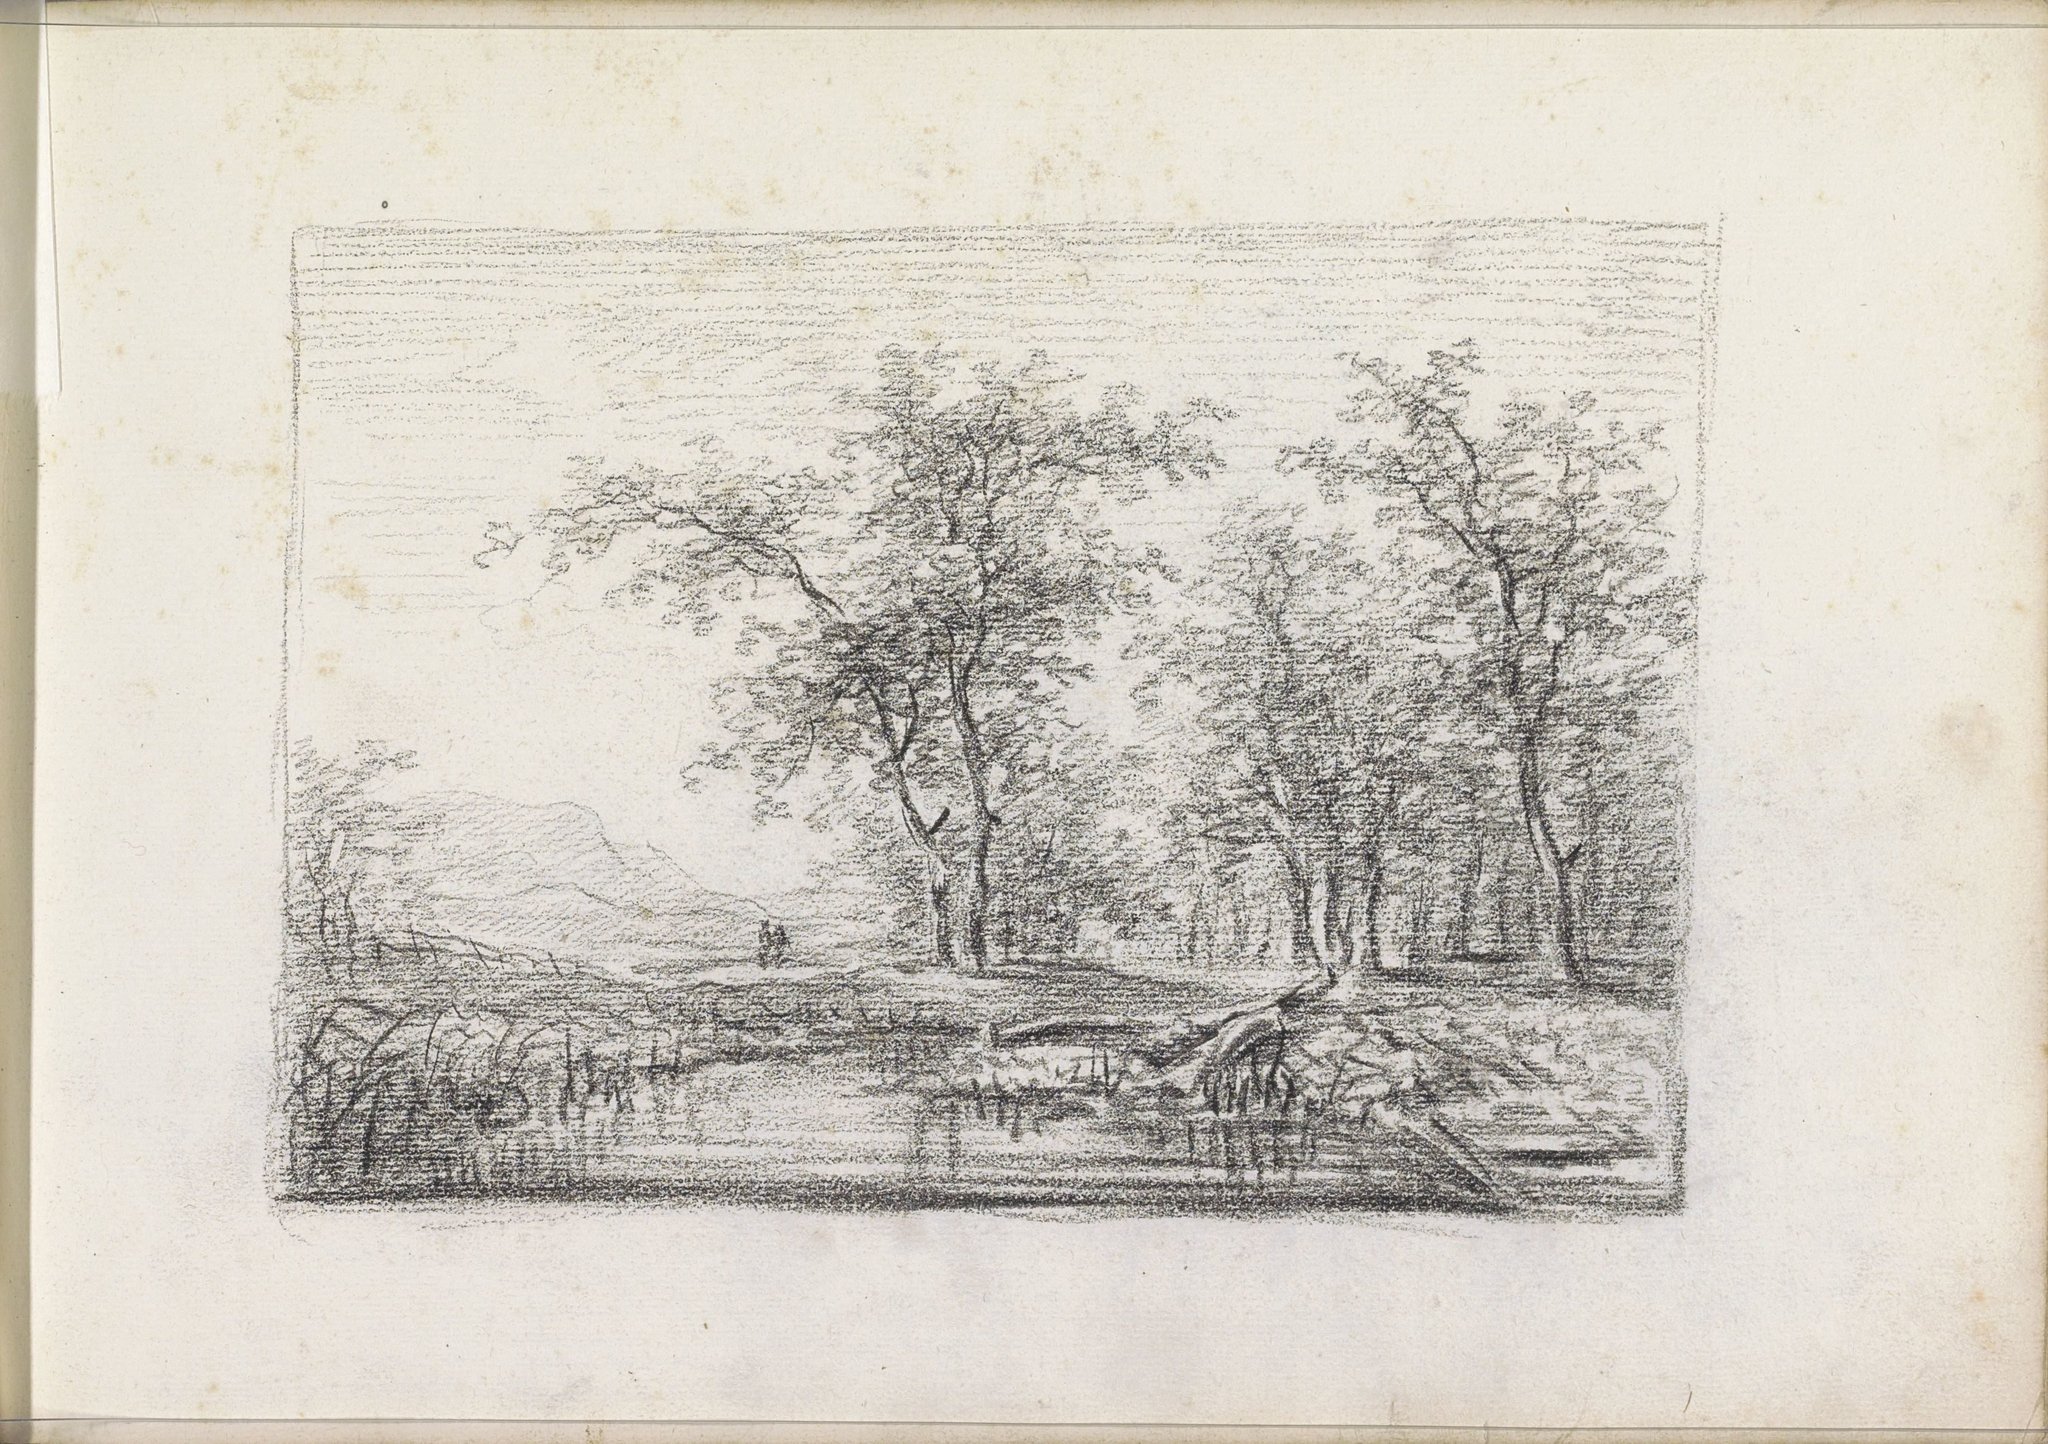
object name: sketchbook leaf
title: Landschap met bomen, bergen en een plas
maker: andreas schelfhout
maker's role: draughtsman, painter, print maker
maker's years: 1787-1870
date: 1811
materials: chalk, paper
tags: landscapes with waters, waterscapes, seascapes (in the temperate zone) (+ landscape with figures, staffage), mountains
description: Blad 15 recto uit een schetsboek met 75 bladen.